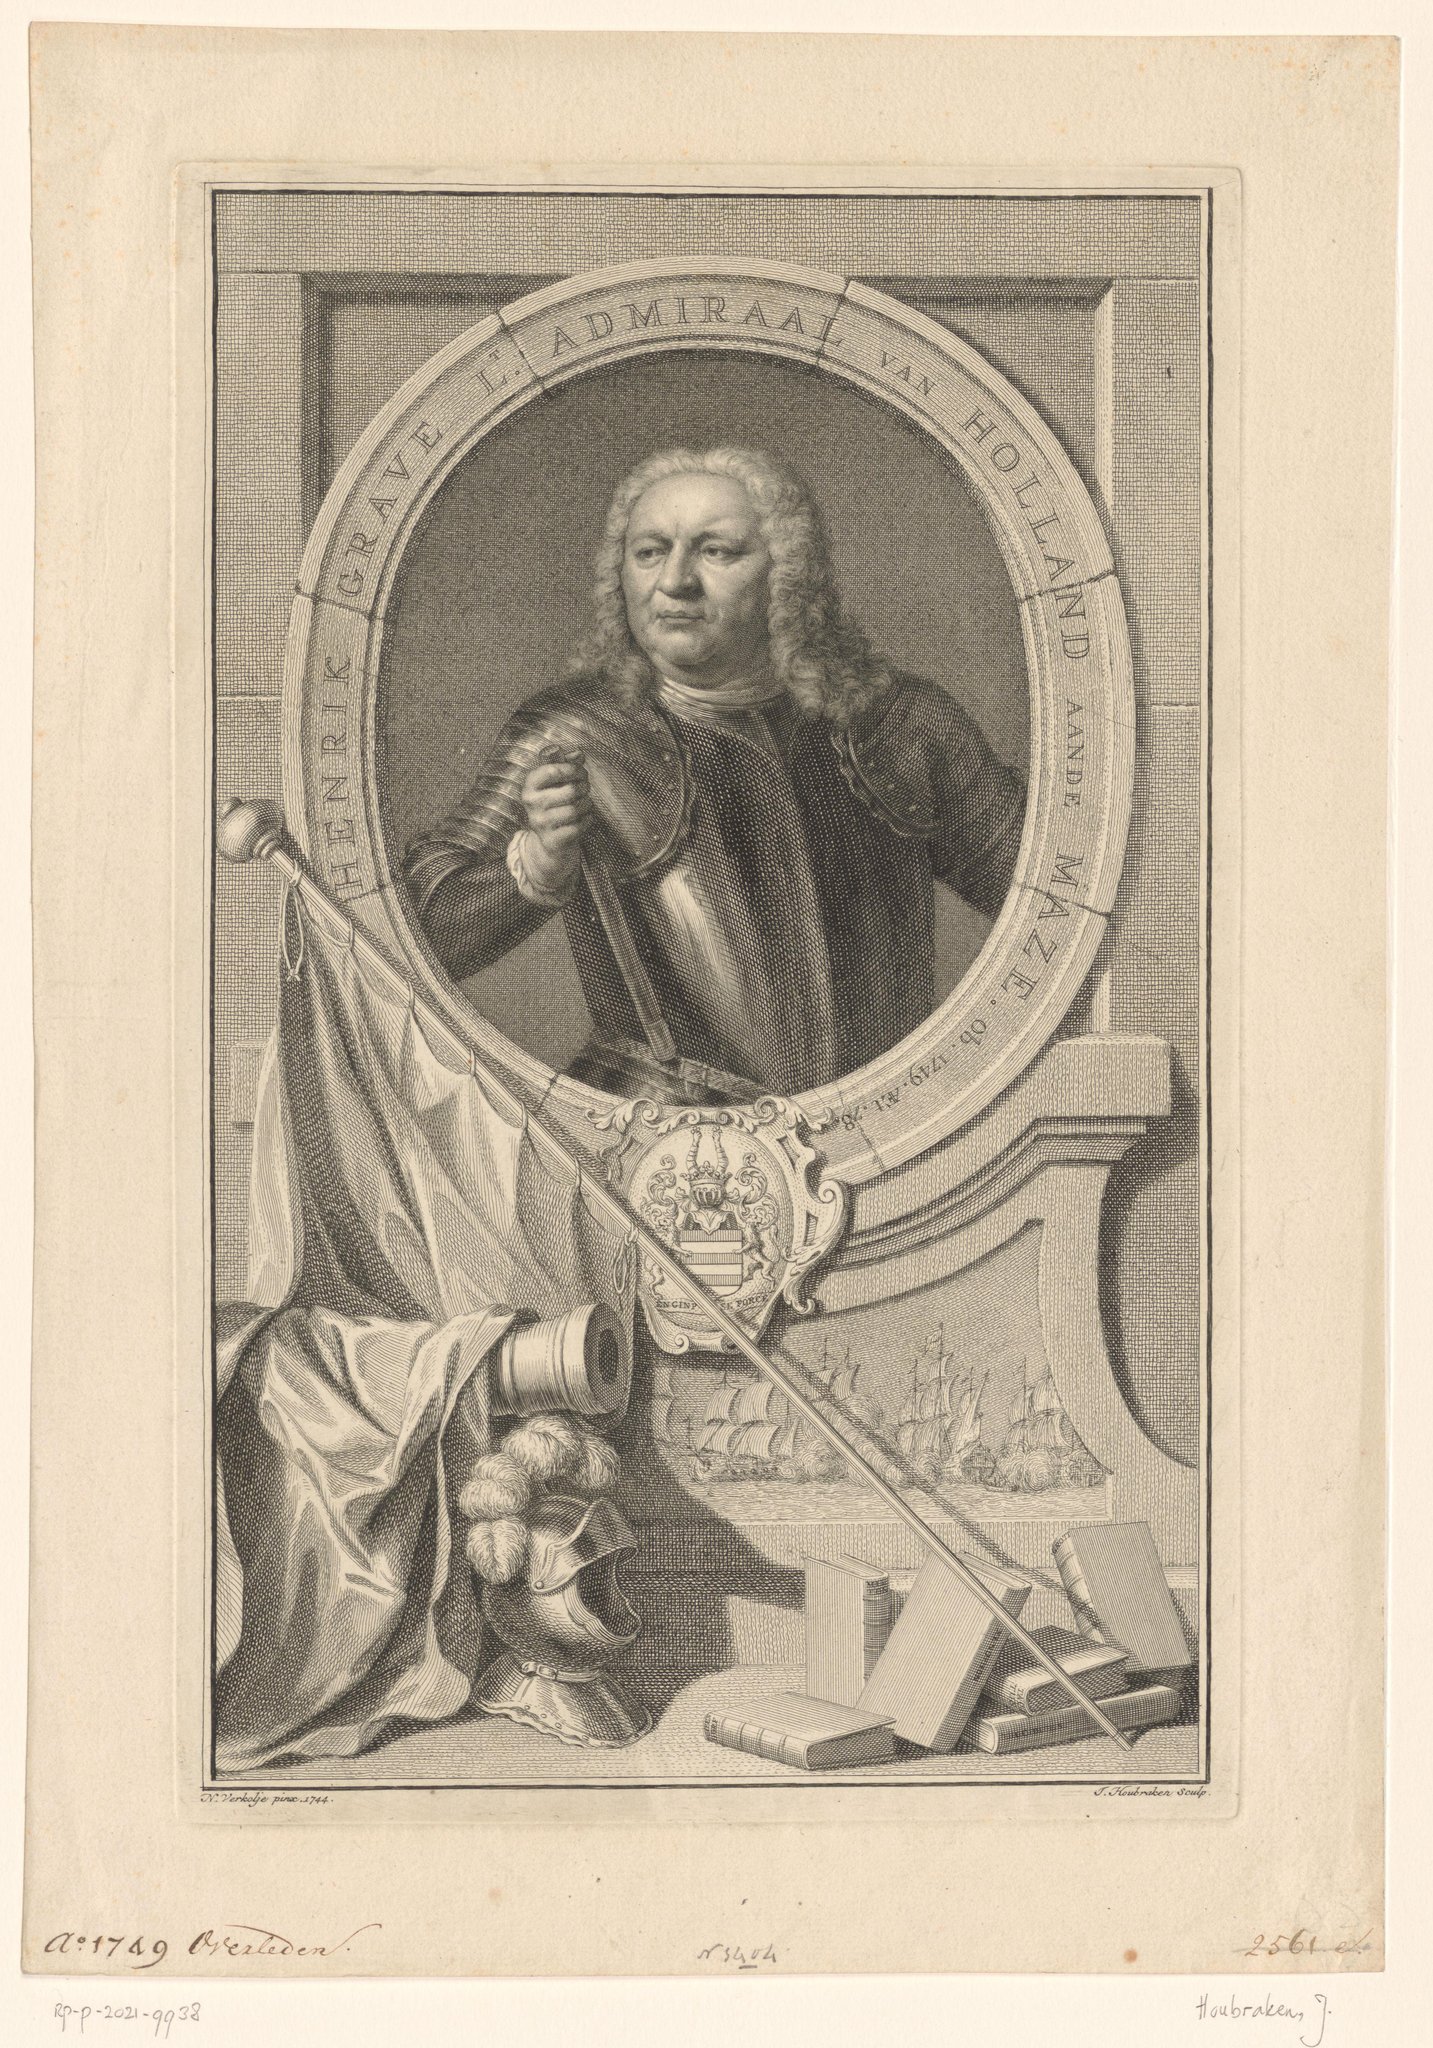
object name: print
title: Portret van Hendrik Gravé op 78-jarige leeftijd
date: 1749-1780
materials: paper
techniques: engraving, etching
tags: amsterdam, historical persons, book, warfare; military affairs (+ naval force), armorial bearing, heraldry